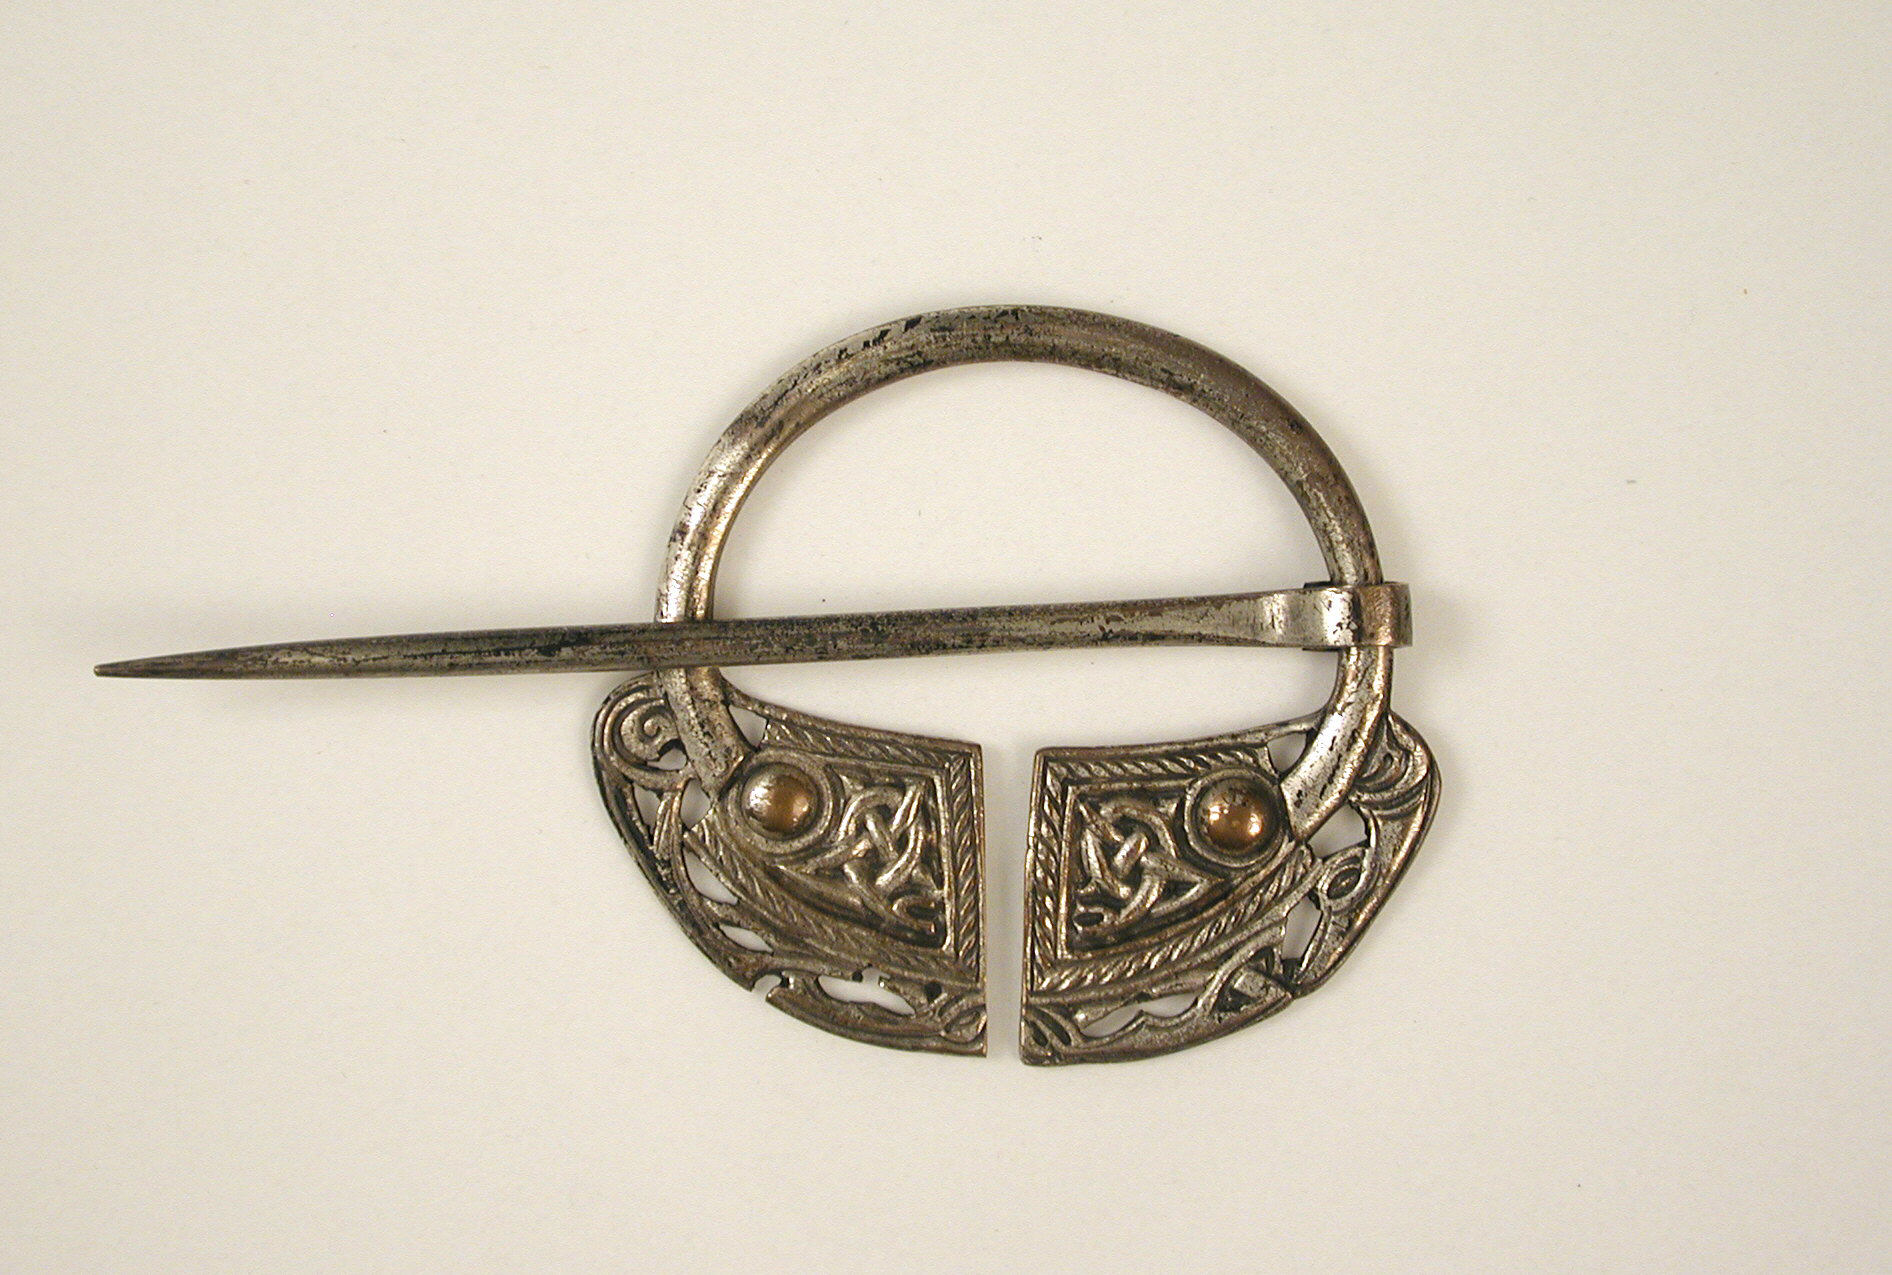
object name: brooch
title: Celtic Brooch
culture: irish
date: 1901-1933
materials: silver